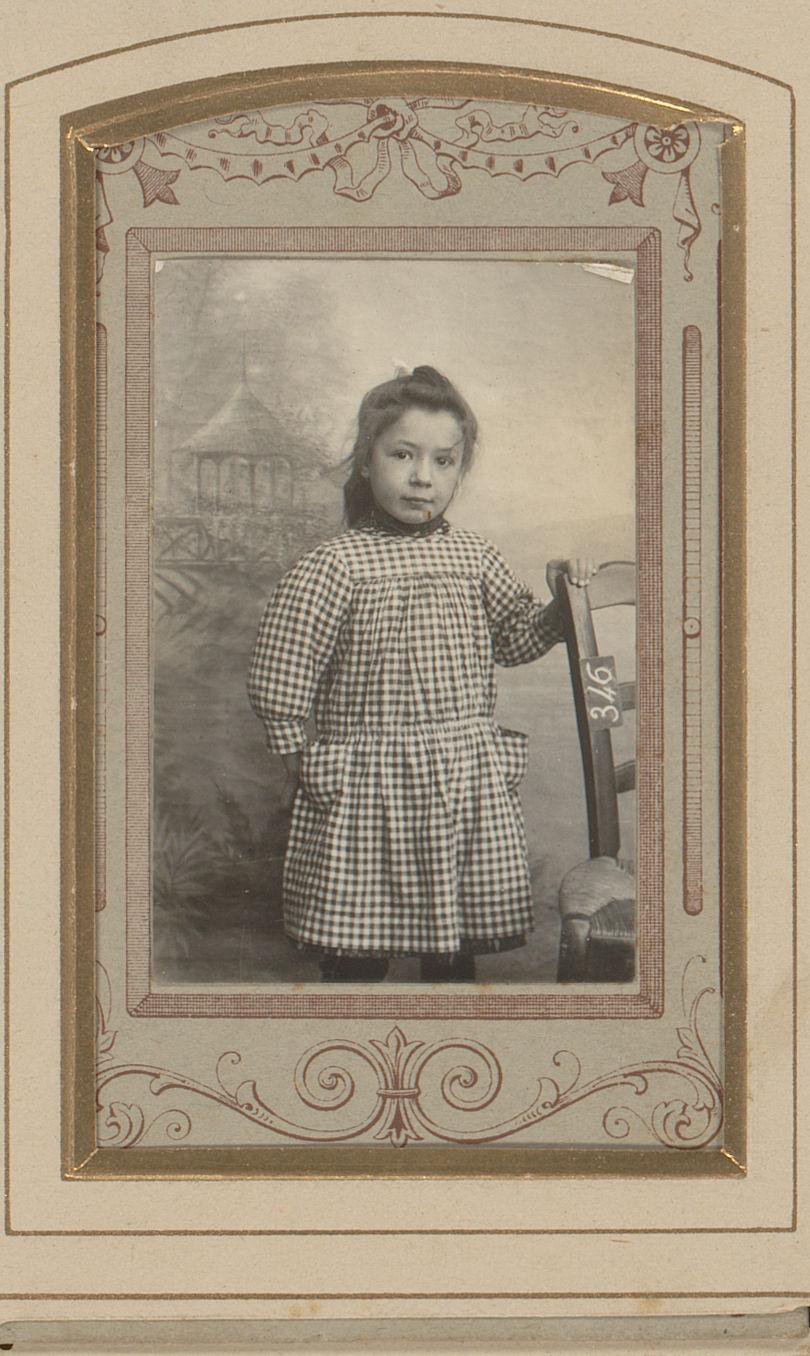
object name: carte de visite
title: Portret van een meisje, staand bij een stoel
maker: alphonse charles dumesnil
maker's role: fotograaf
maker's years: 1836-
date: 1880-1930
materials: cardboard, photographic support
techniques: gelatin silver print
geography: vincennes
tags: historical persons - bb - woman, girl (child between toddler and youth), chair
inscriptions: inscription: ‘Dumesnil Marguin/ VINCENNES’